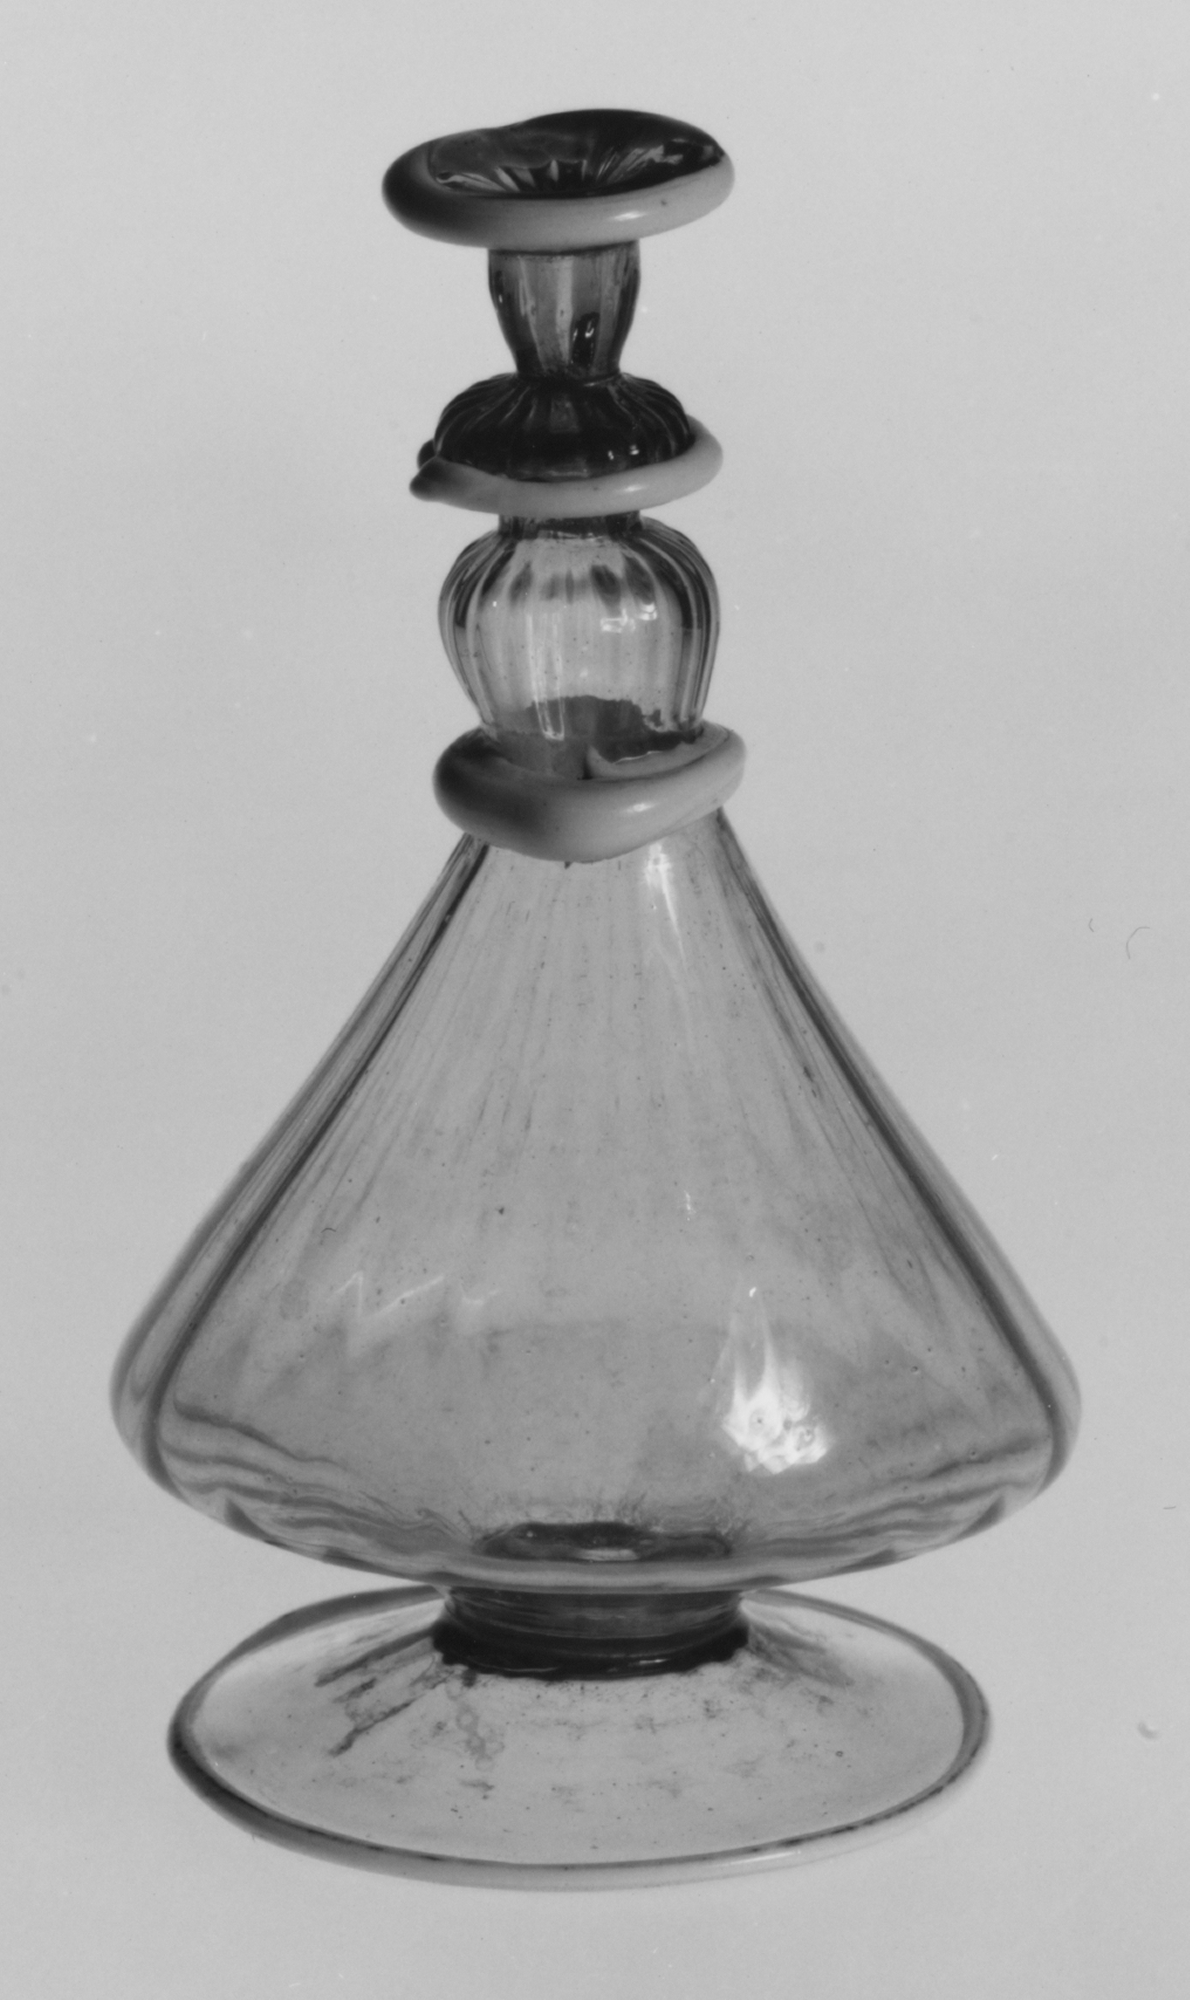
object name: sprinkler bottle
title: Sprinkler bottle(?)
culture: façon de venise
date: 1601-1700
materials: glass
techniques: glassblowing, molding